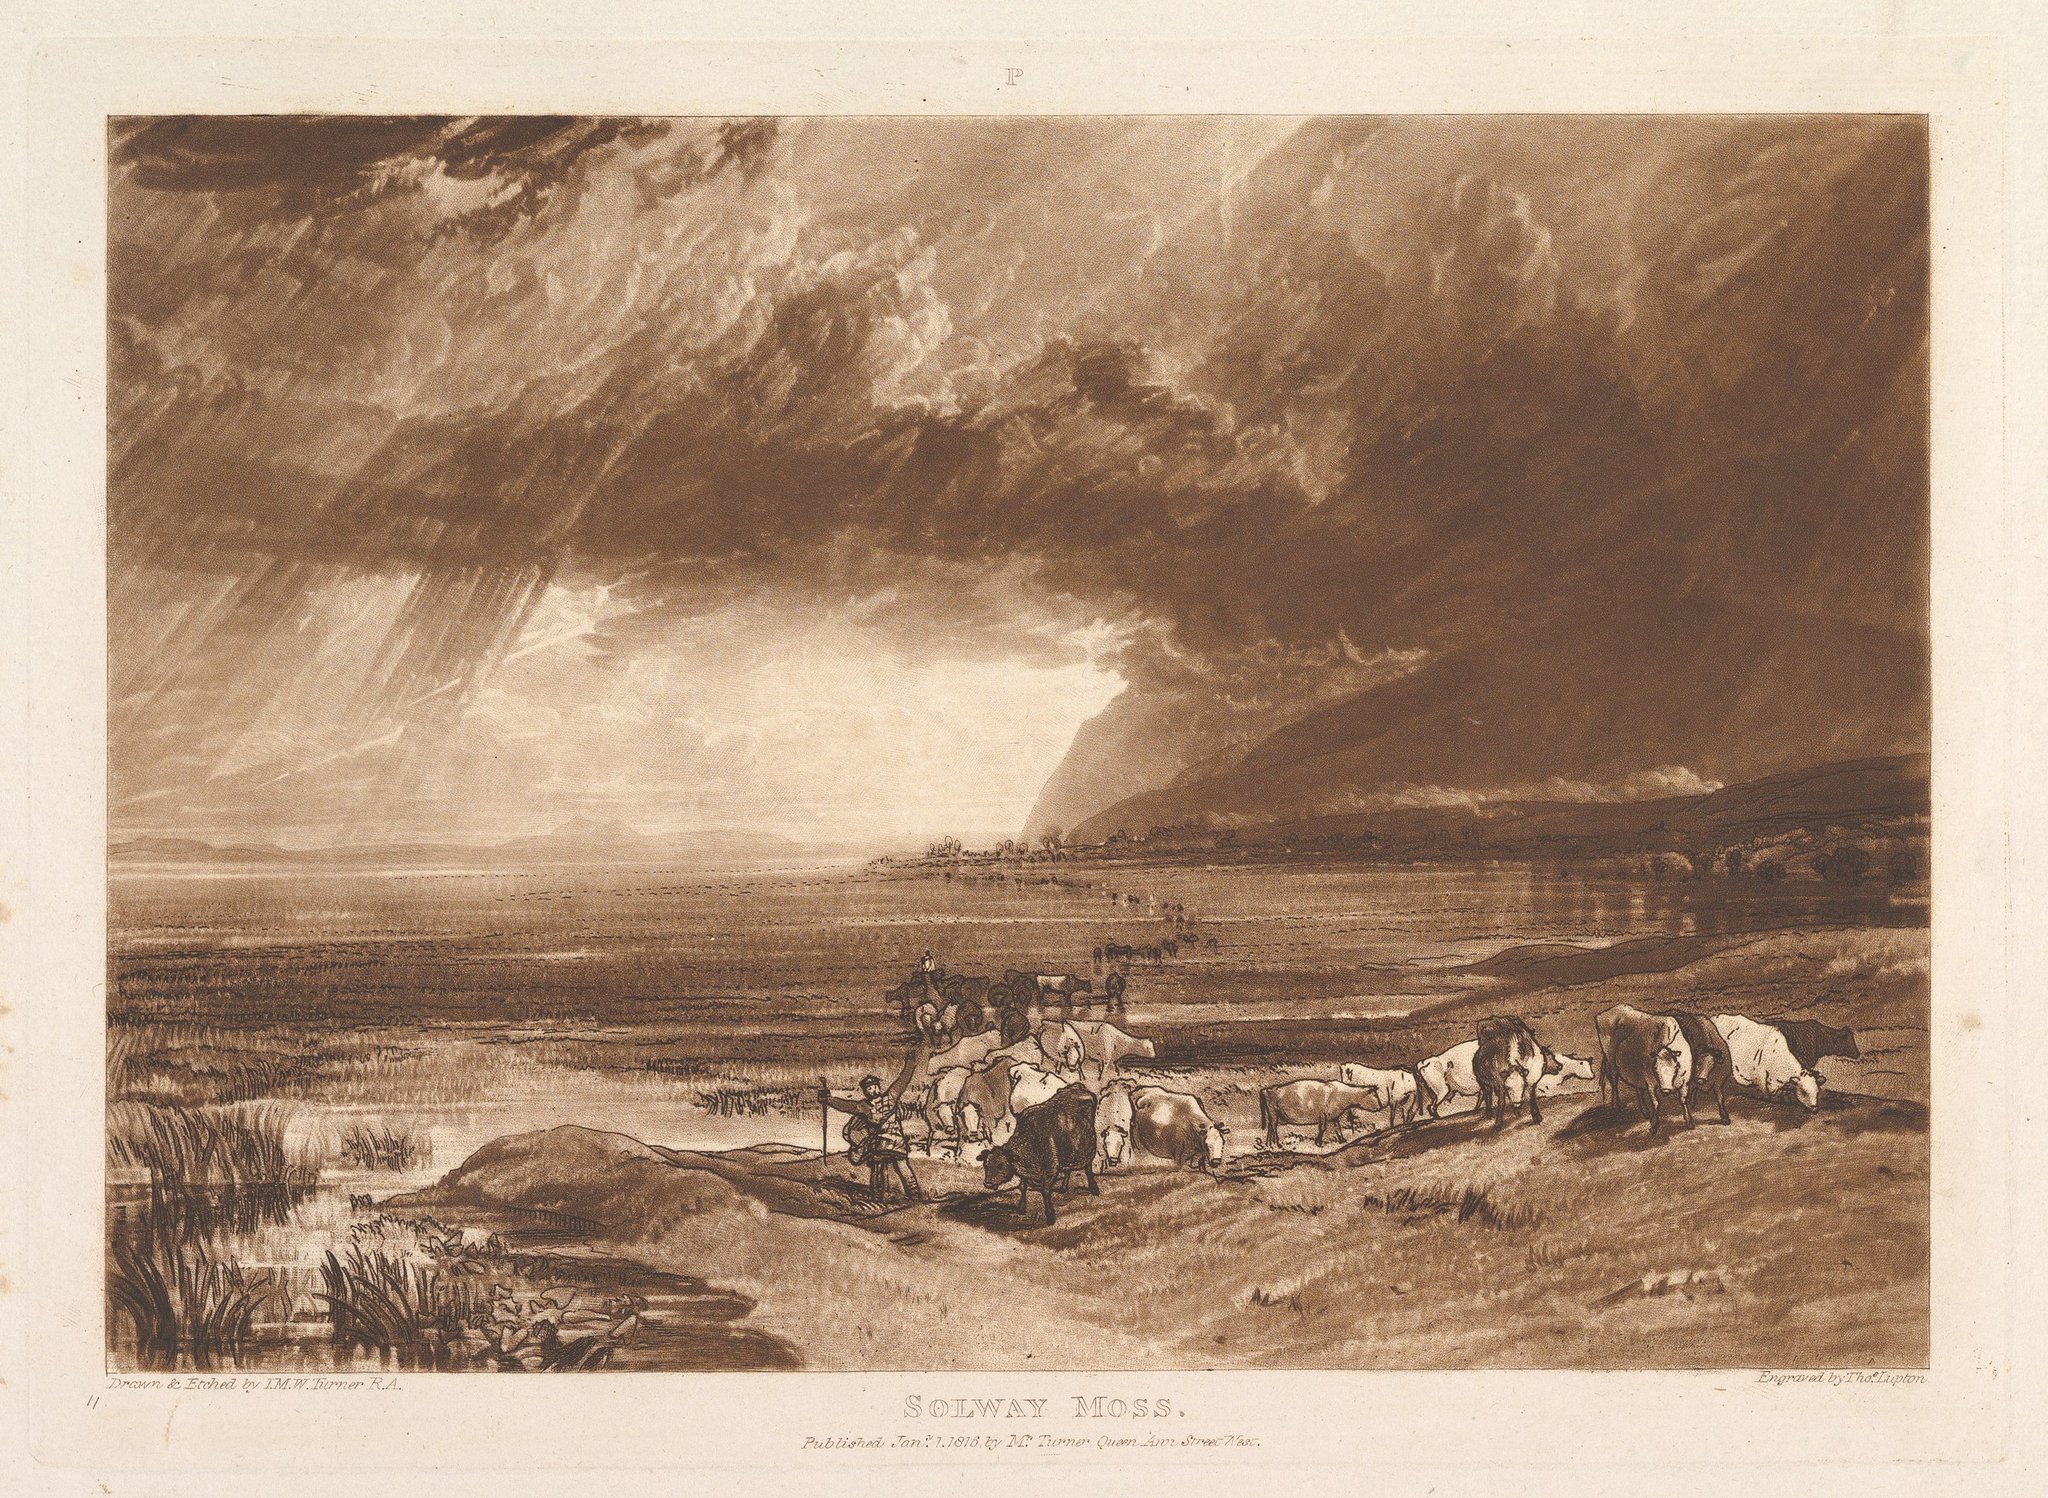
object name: print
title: Solway Moss (Liber Studiorum, part XI, plate 52)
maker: joseph mallord william turner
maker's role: artist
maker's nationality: british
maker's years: 1775-1851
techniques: etching, mezzotint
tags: cows,landscapes